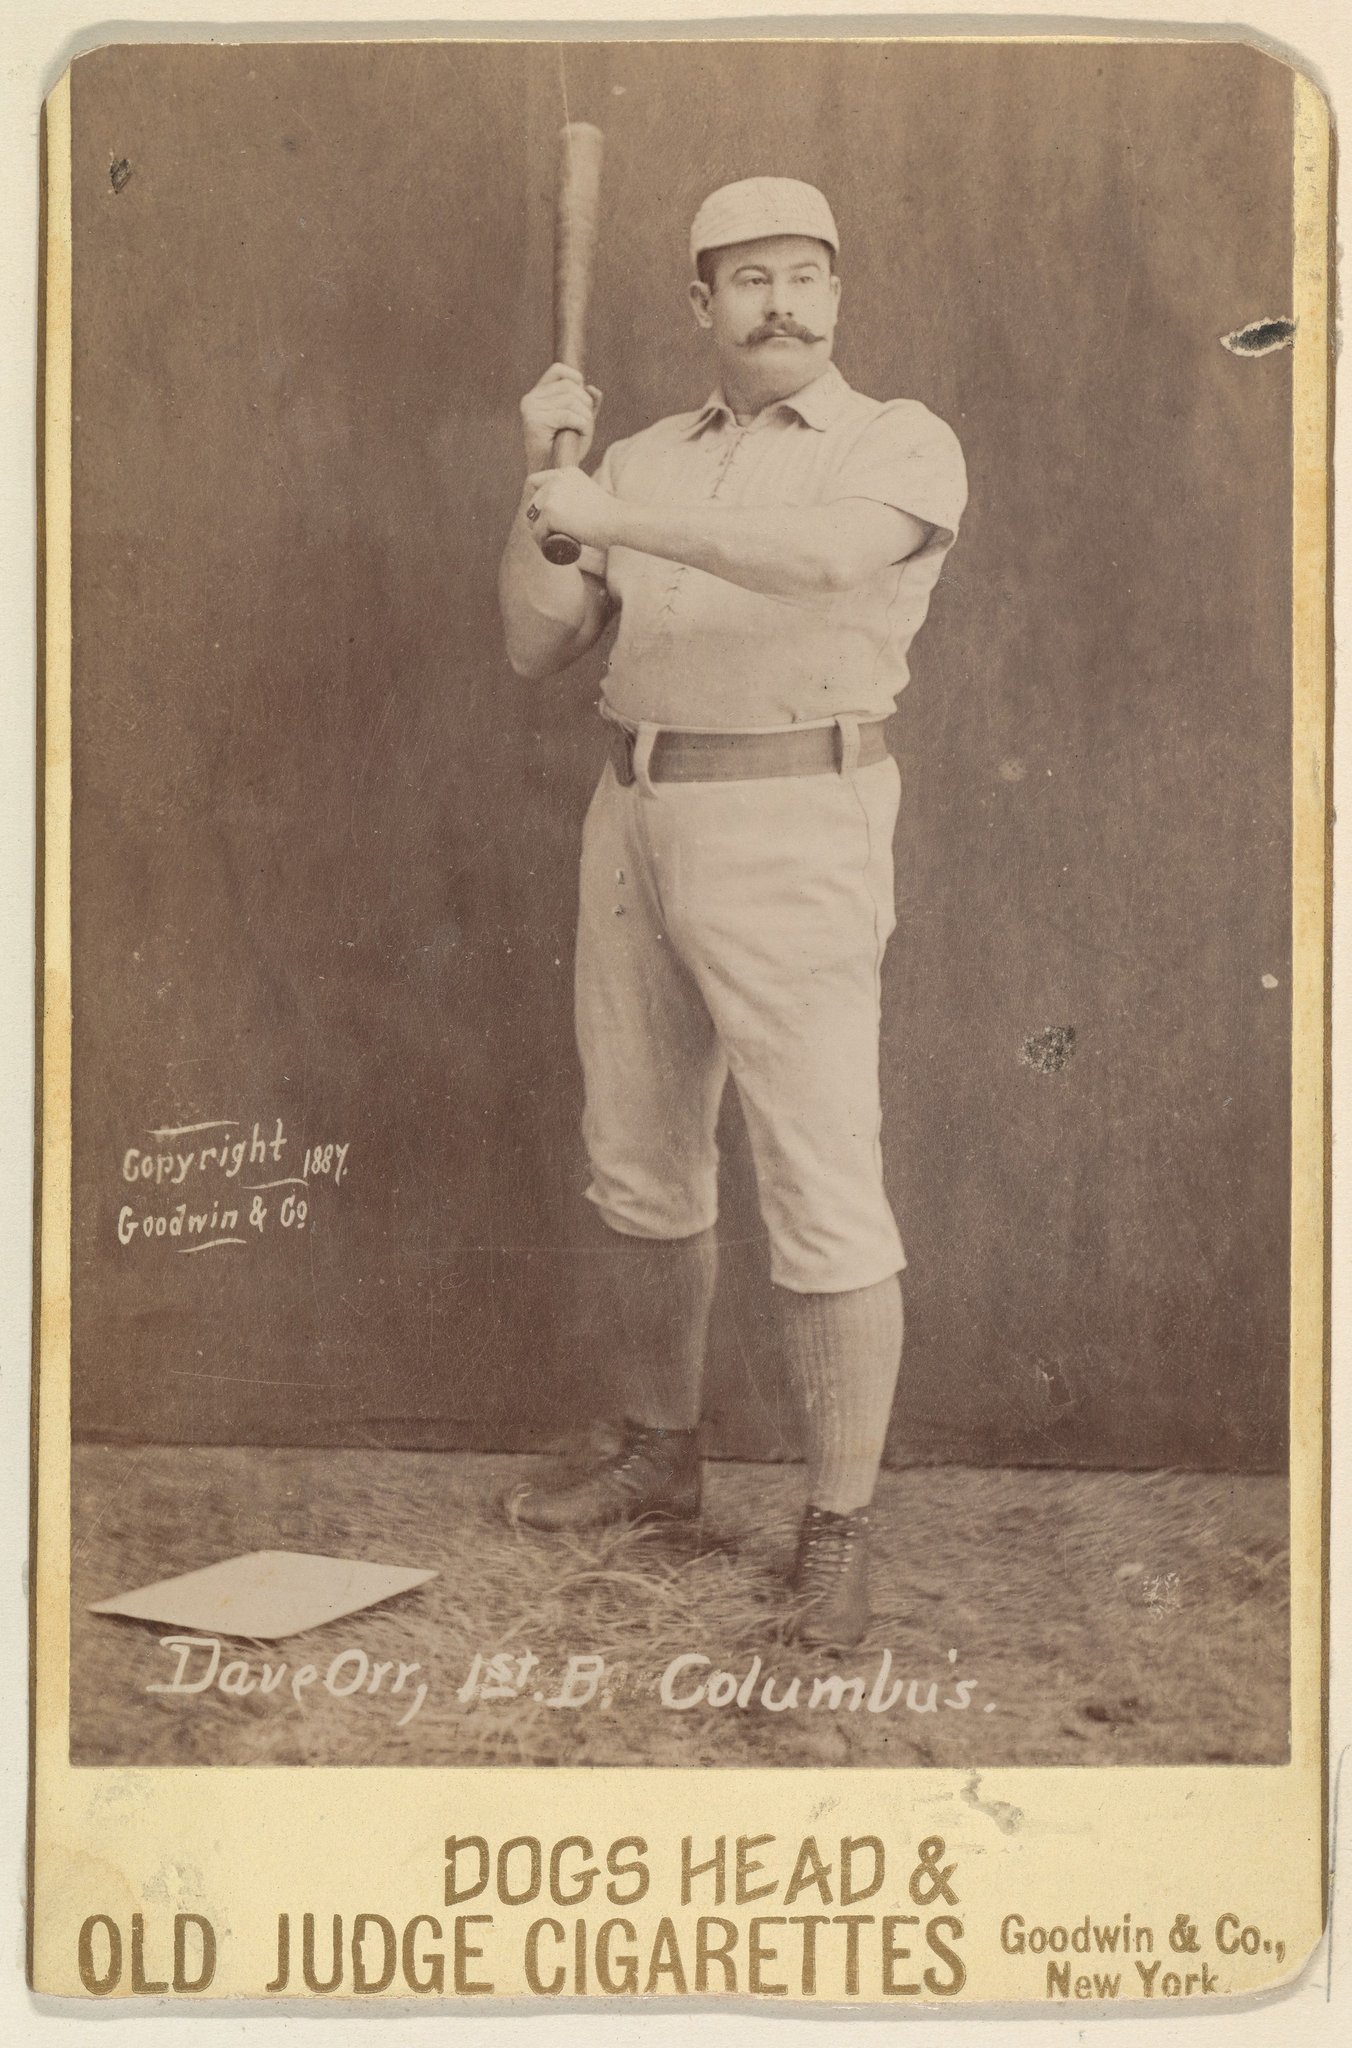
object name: baseball card, photograph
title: Dave Orr, 1st Base, Columbus, from the series Old Judge Cigarettes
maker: goodwin & company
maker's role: publisher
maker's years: 1850-1950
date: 1888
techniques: albumen print, photography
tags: men,portraits,baseball,athletes